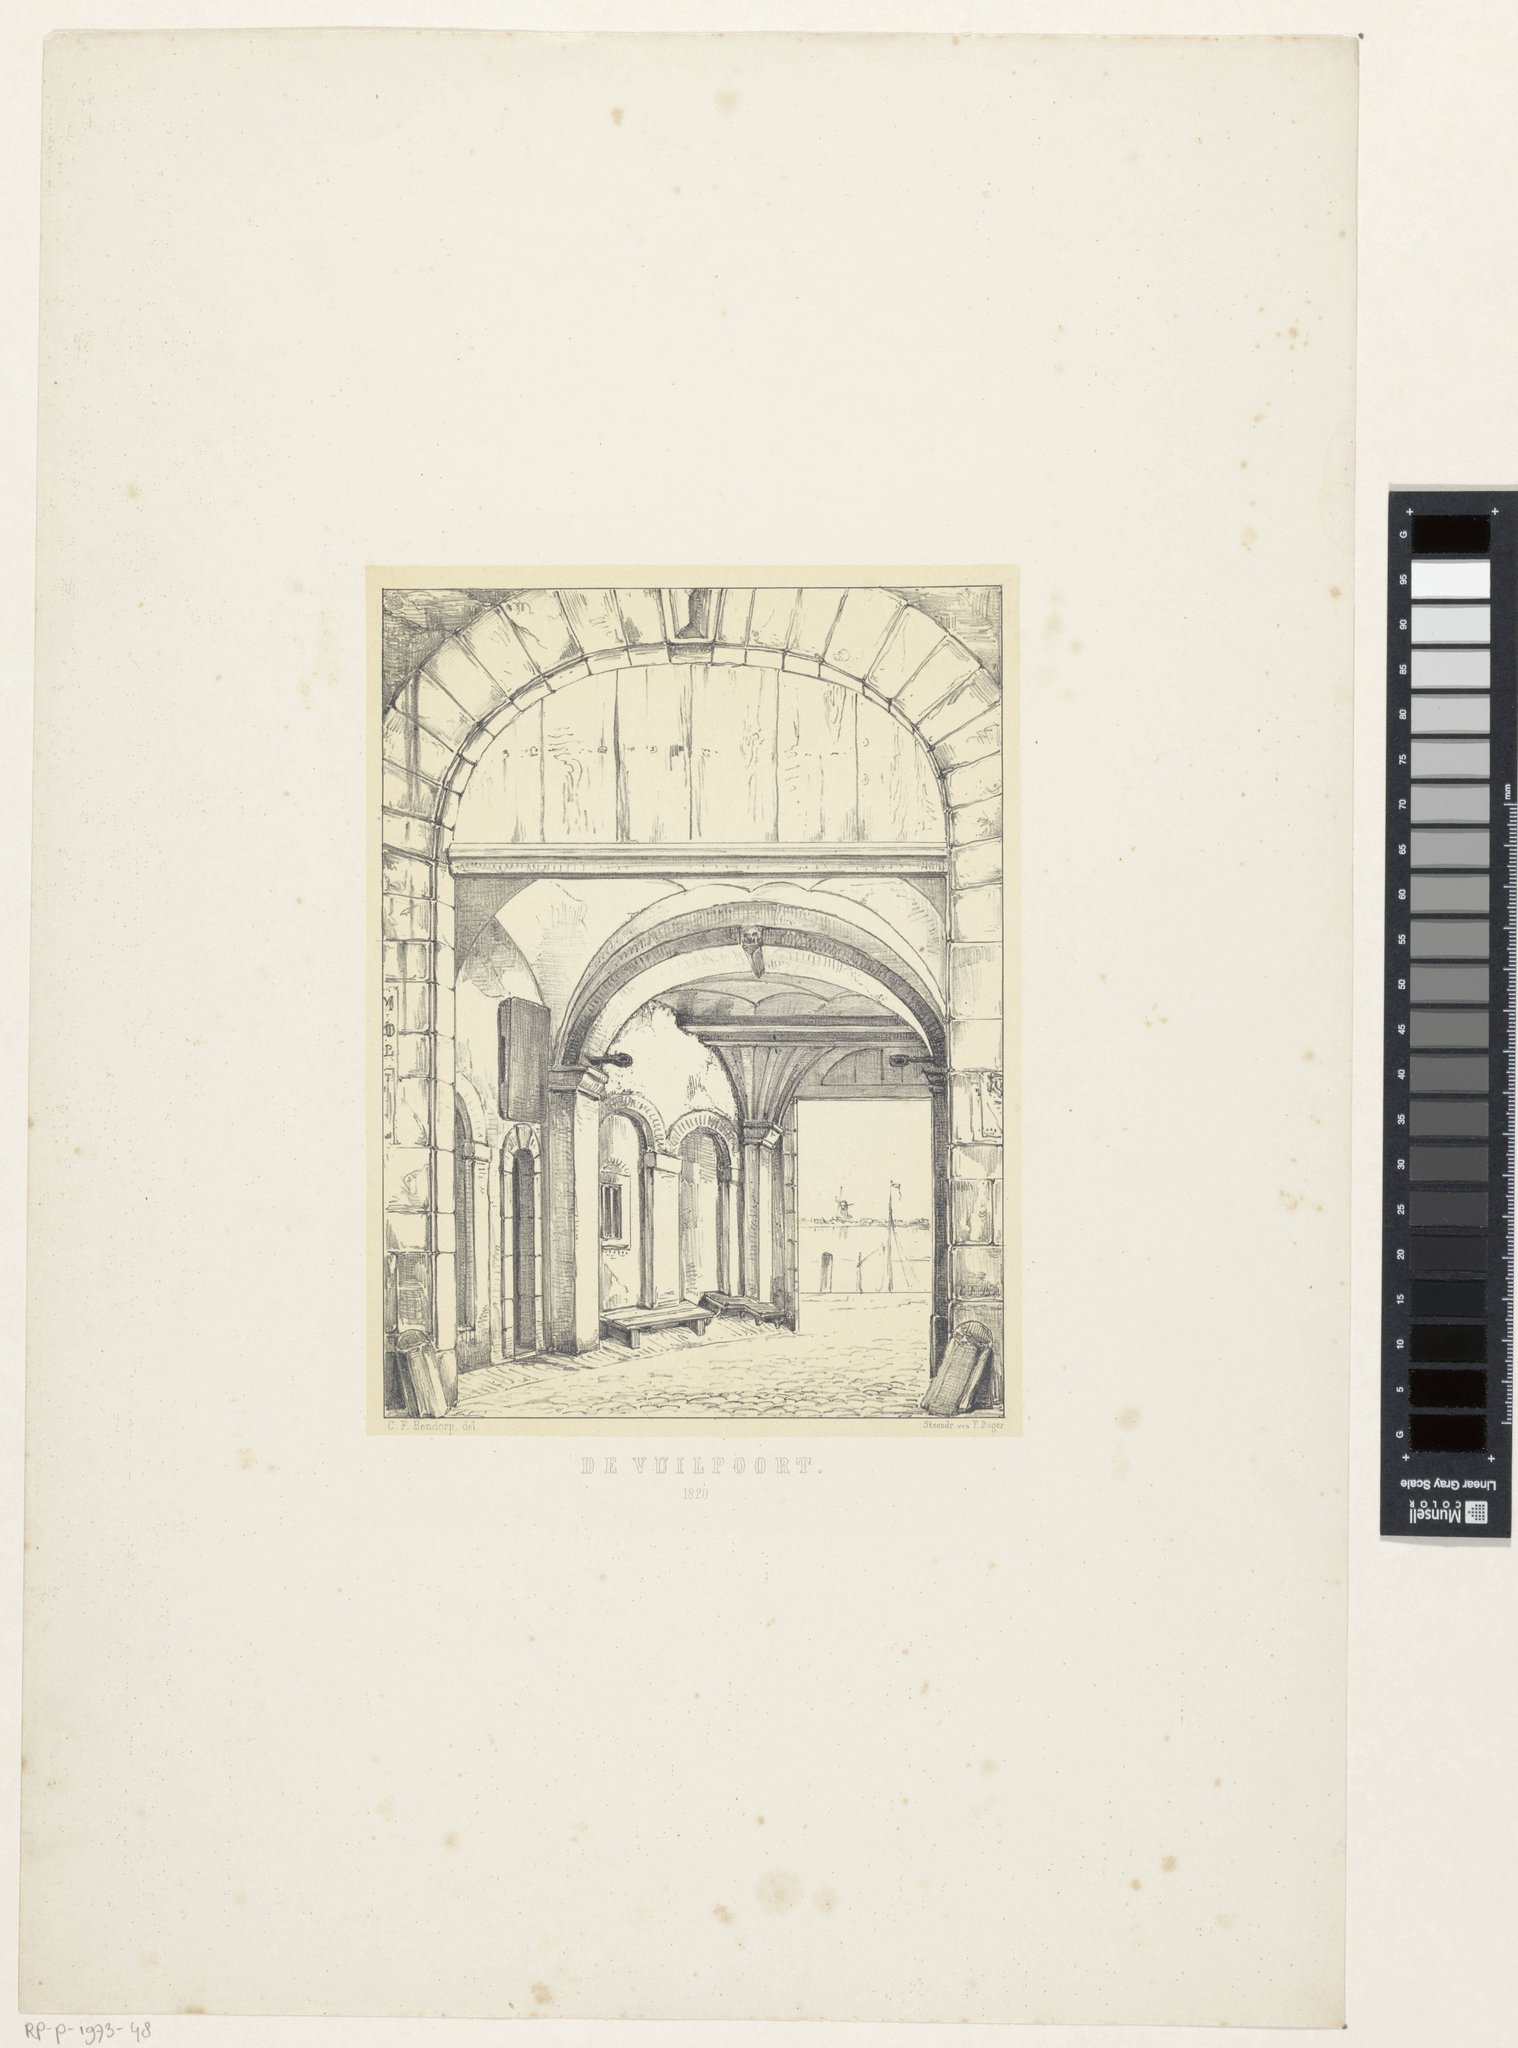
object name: print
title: Dordrecht zoals het vroeger was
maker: carel frederik bendorp (ii)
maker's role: draughtsman, painter, print maker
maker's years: 1819-1897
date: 1872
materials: paper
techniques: tone lithography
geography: dordrecht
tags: windmill in landscape, city-gate, dordrecht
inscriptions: collector's mark: Lugt 2760, collector's mark: Lugt 2228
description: Aan de andere kant van de poort is een kade, water en in de verte een windmolen. Het plafond van de poort is gewelfd. Onder de afbeelding het jaartal 1820.